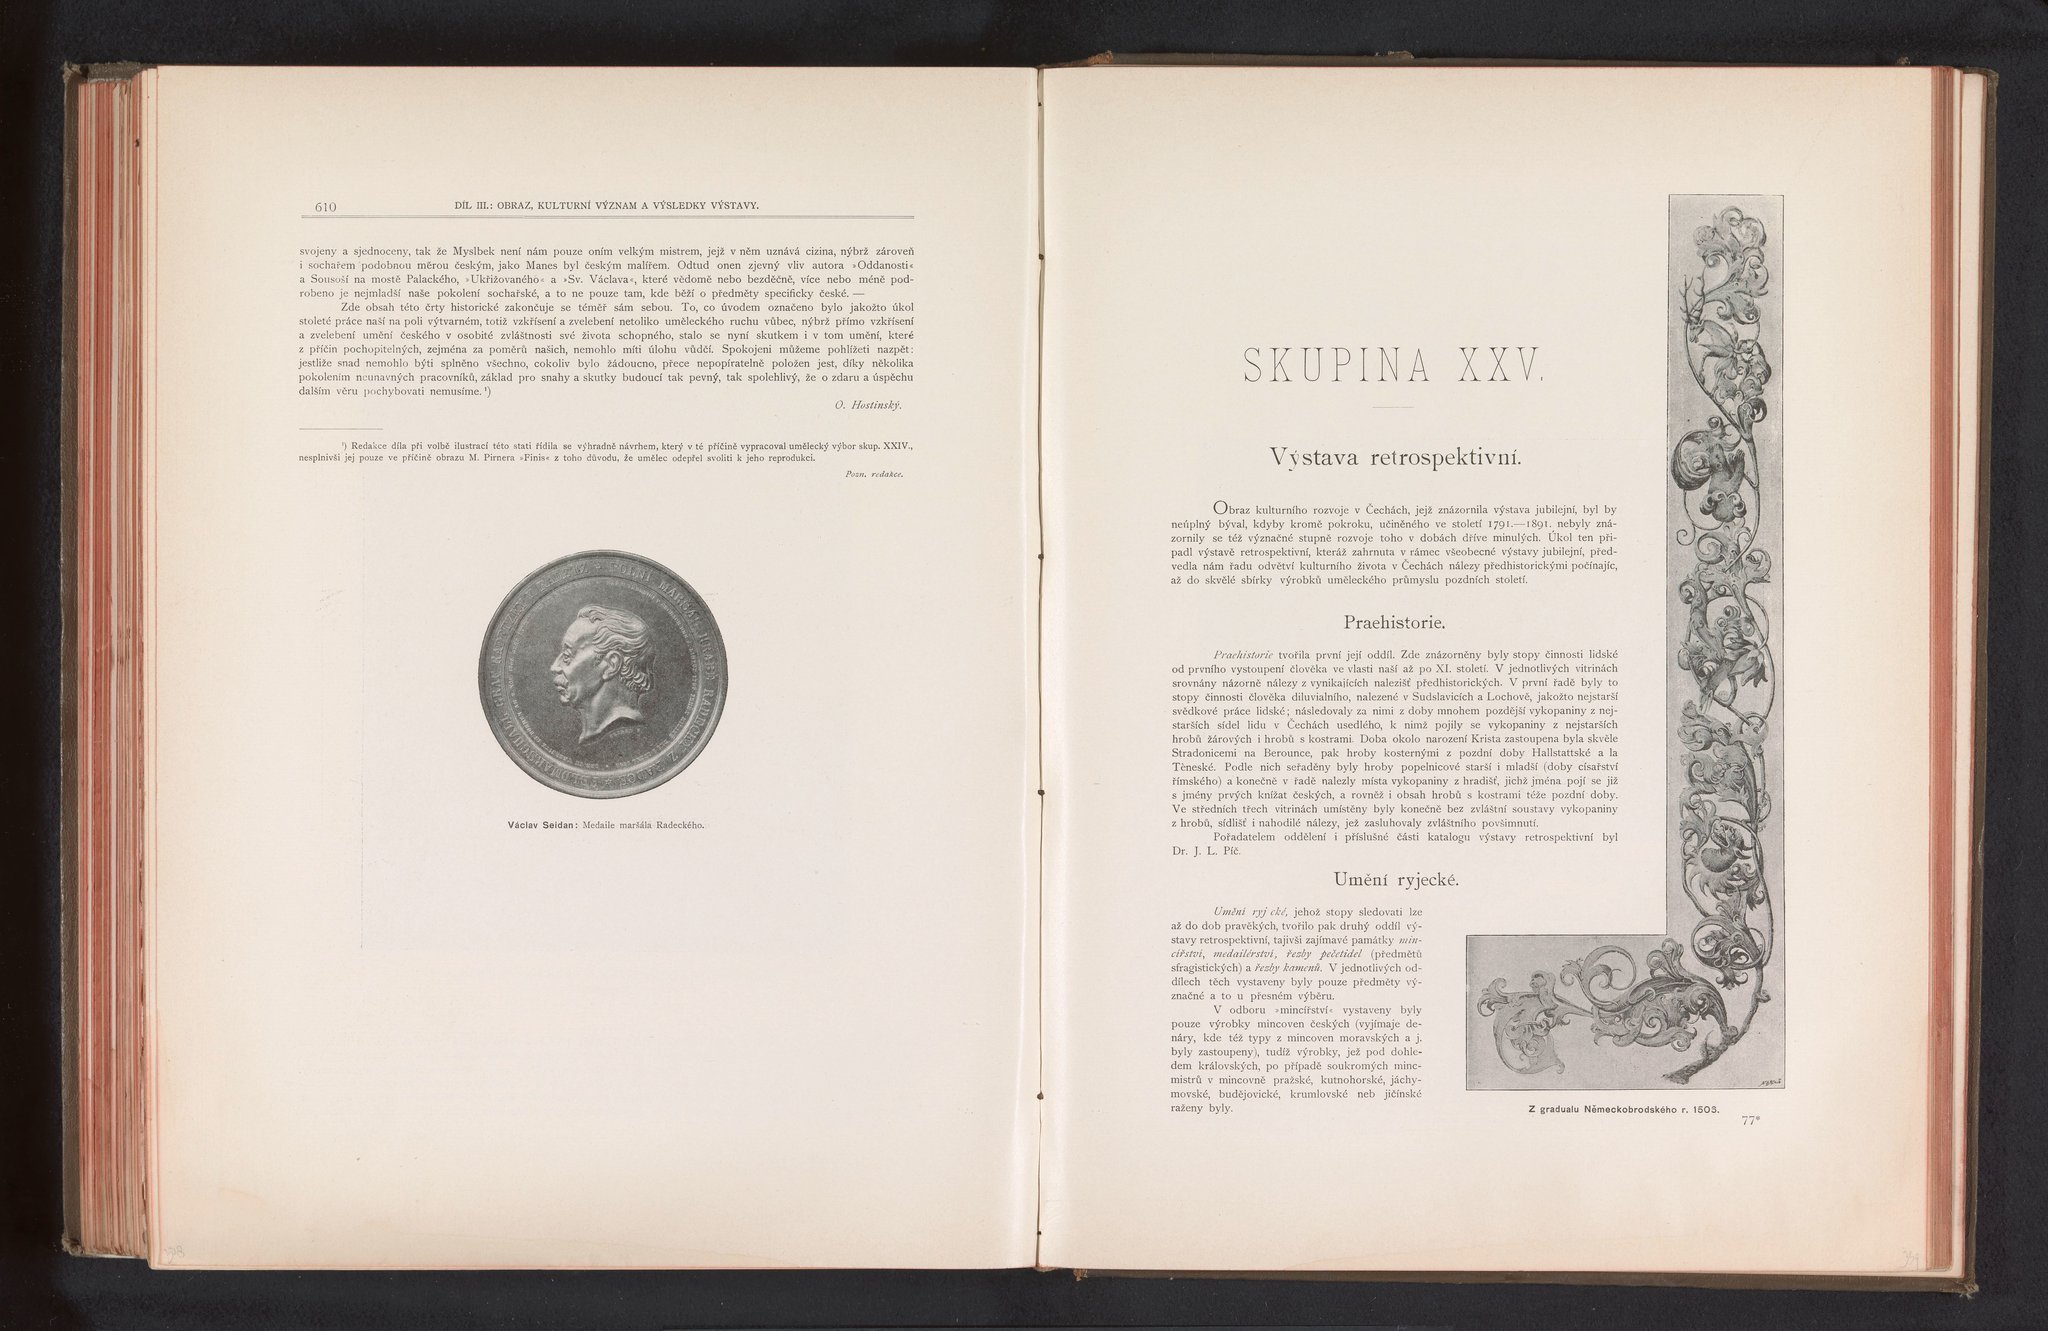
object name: page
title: Václav Seidan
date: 1891-1895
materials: paper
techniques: autotype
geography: prague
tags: medal (considered as a piece of sculpture, regardless of its specific function)